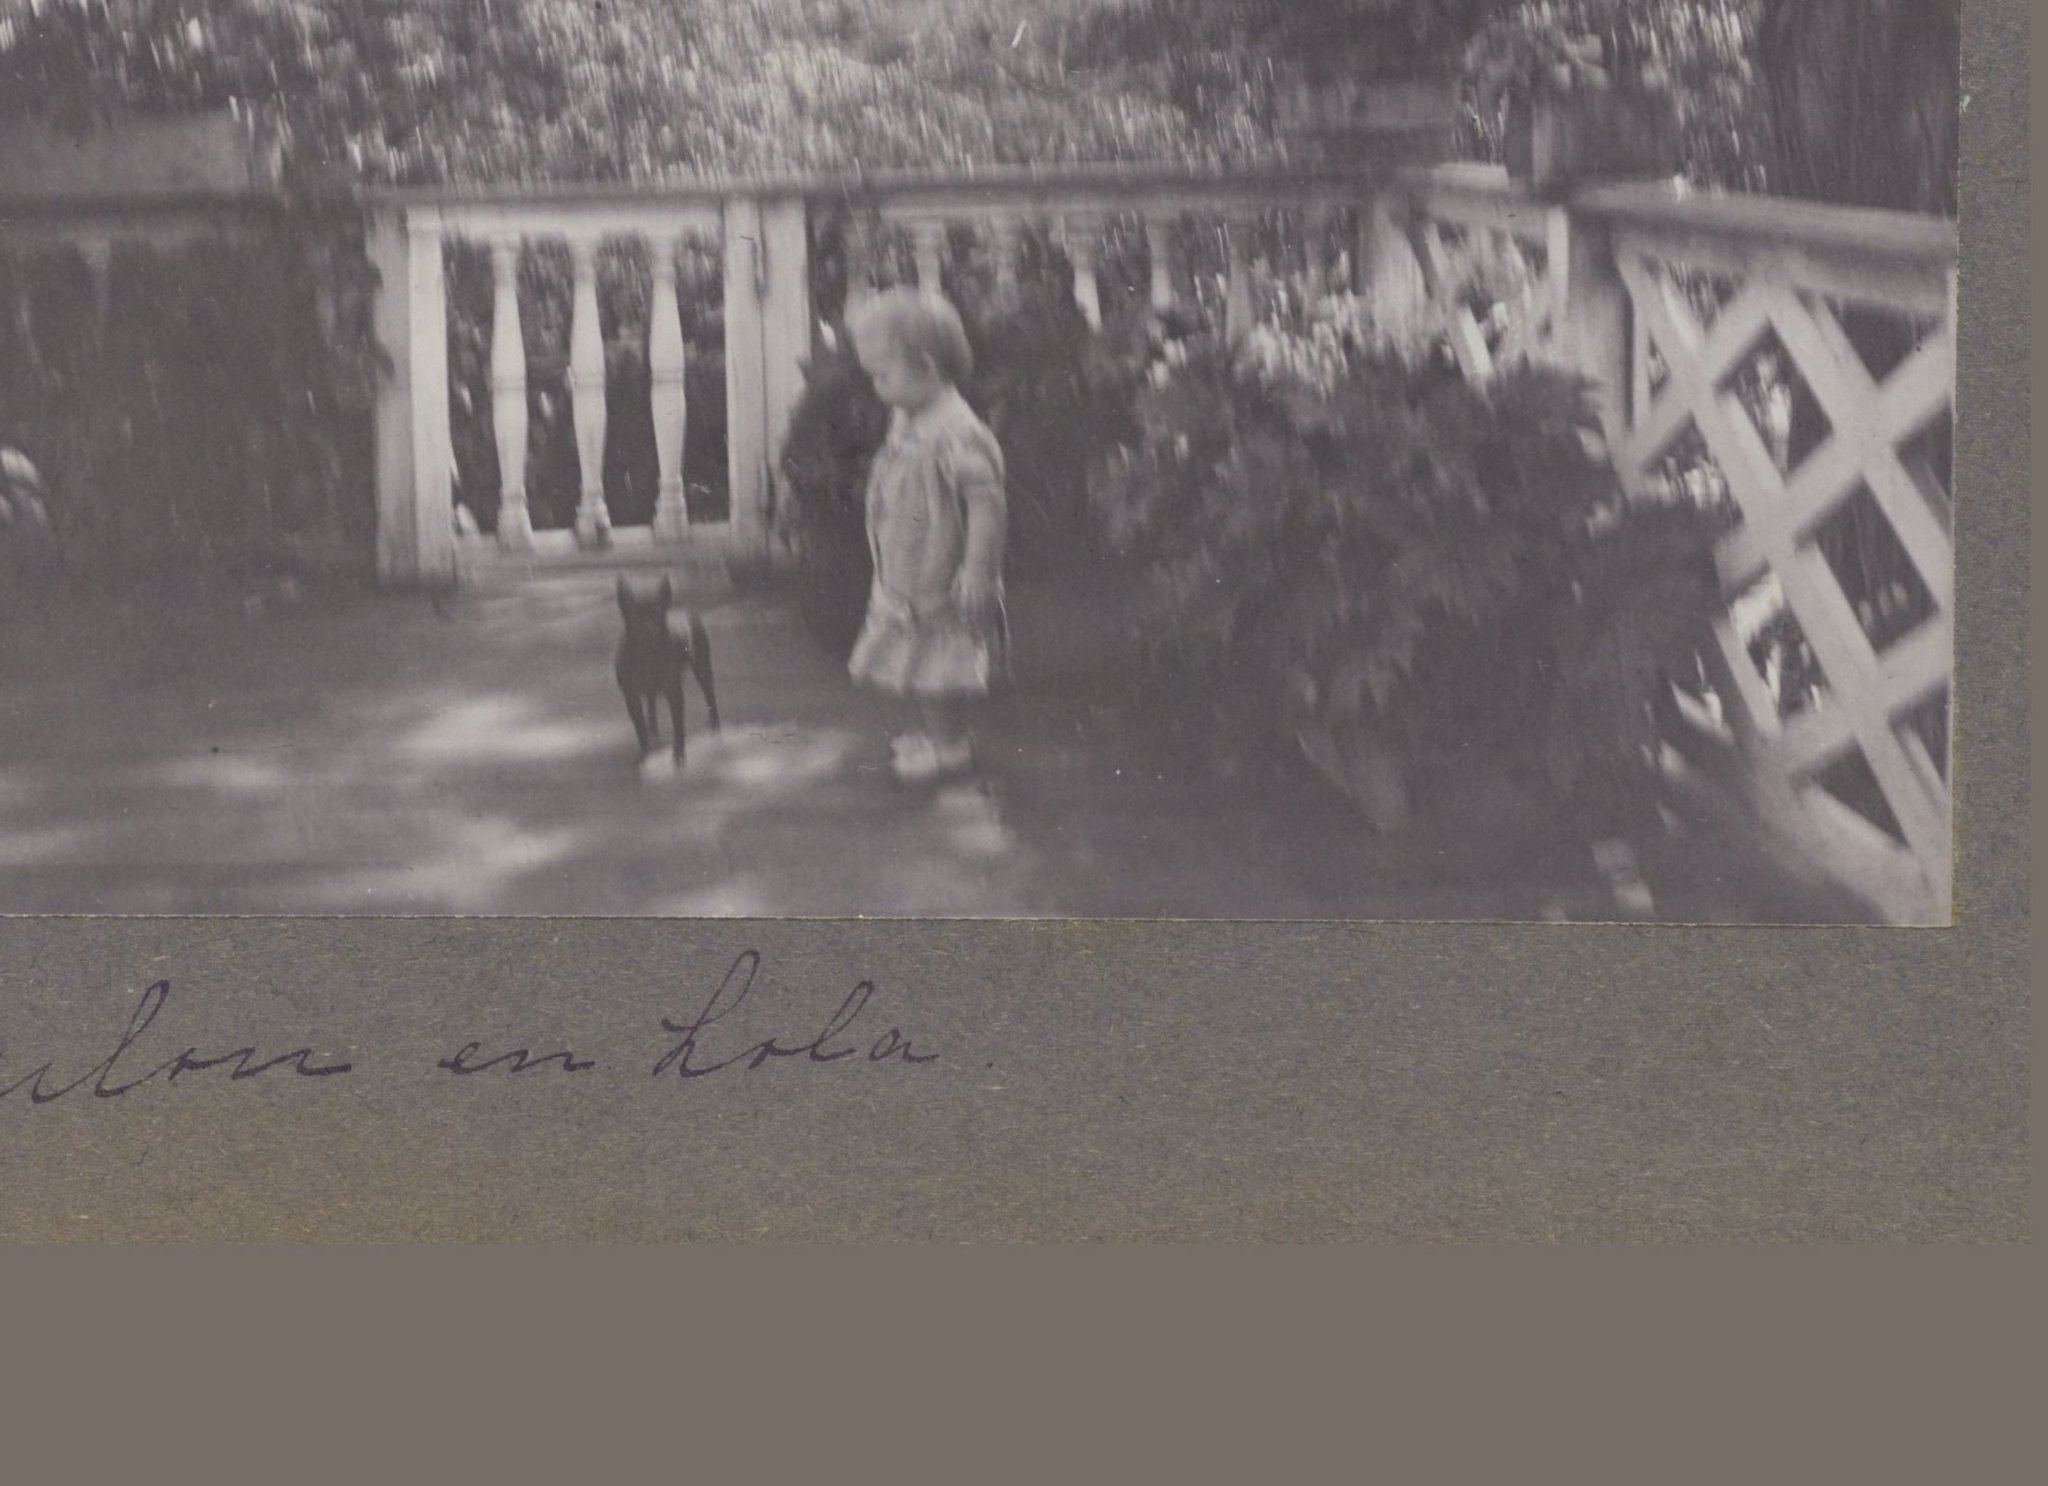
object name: photograph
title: Loulou en Lola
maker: Anonymous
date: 1912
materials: photographic support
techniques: photography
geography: suriname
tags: suriname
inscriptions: inscription: ‘Loulou en Lola’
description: Het kind Loulou met het hondje Lola op een veranda. Onderdeel van het fotoalbum over het leven van de familie Gonggrijp in Suriname rond 1912.